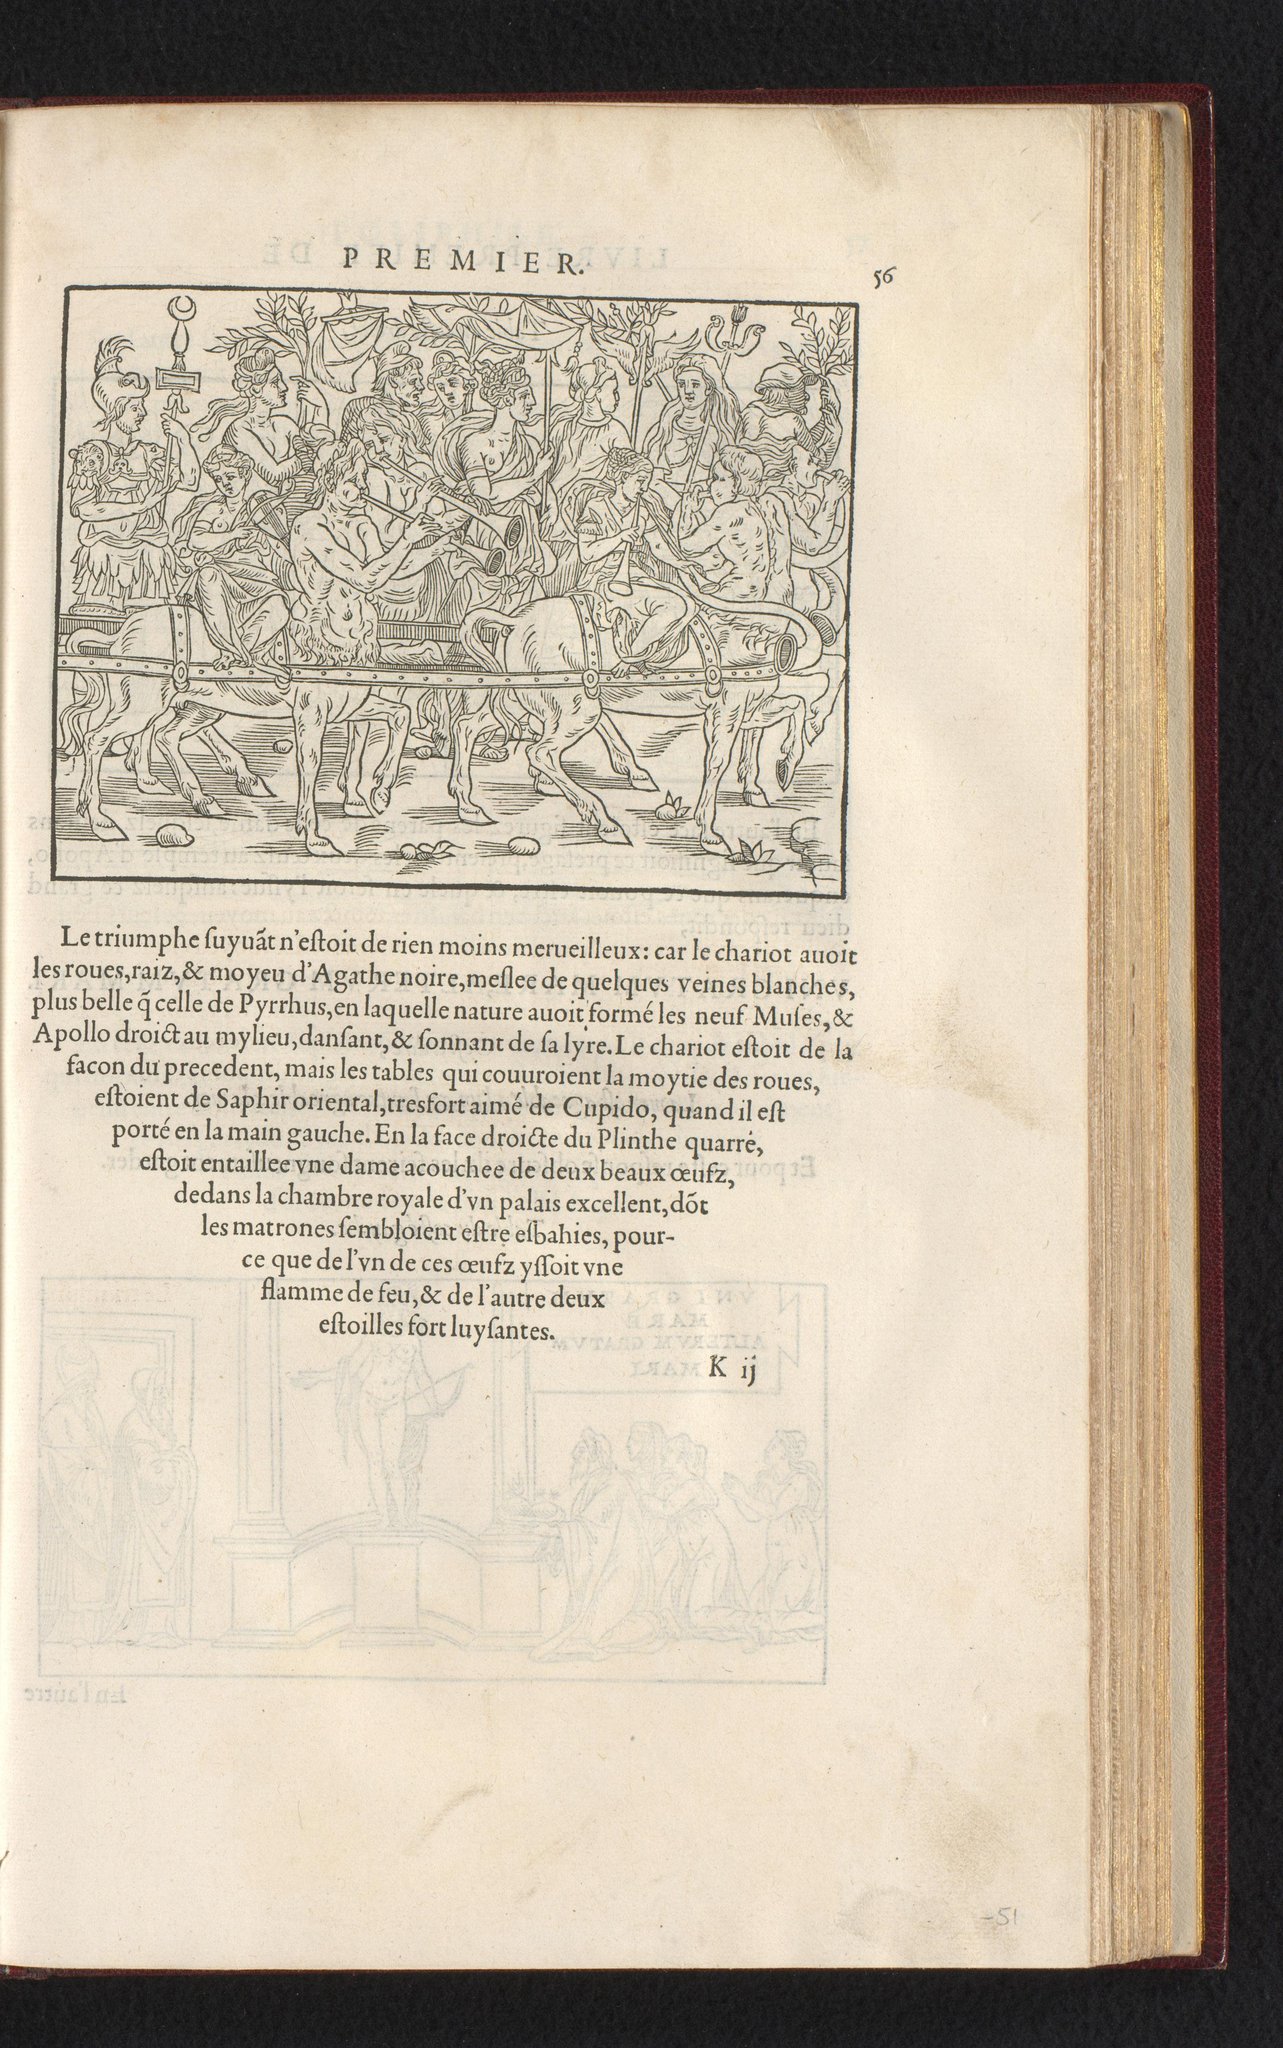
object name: book illustration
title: Optocht van centaurs en nimfen die een triomfwagen trekken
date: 1546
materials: paper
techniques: letterpress printing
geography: paris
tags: centaurs, (scenes from) specific works of literature: colonna, hypnerotomachia poliphili, nymphs (in general); 'ninfe in commune' (ripa)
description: Prent uit: Colonna, Francesco. Hypnerotomachie ou discours du songe de Poliphile, deduisant comme amour le combat a l'occasion de Polia. Parijs: Jacques Kerver, 1546, recto fol. 56.